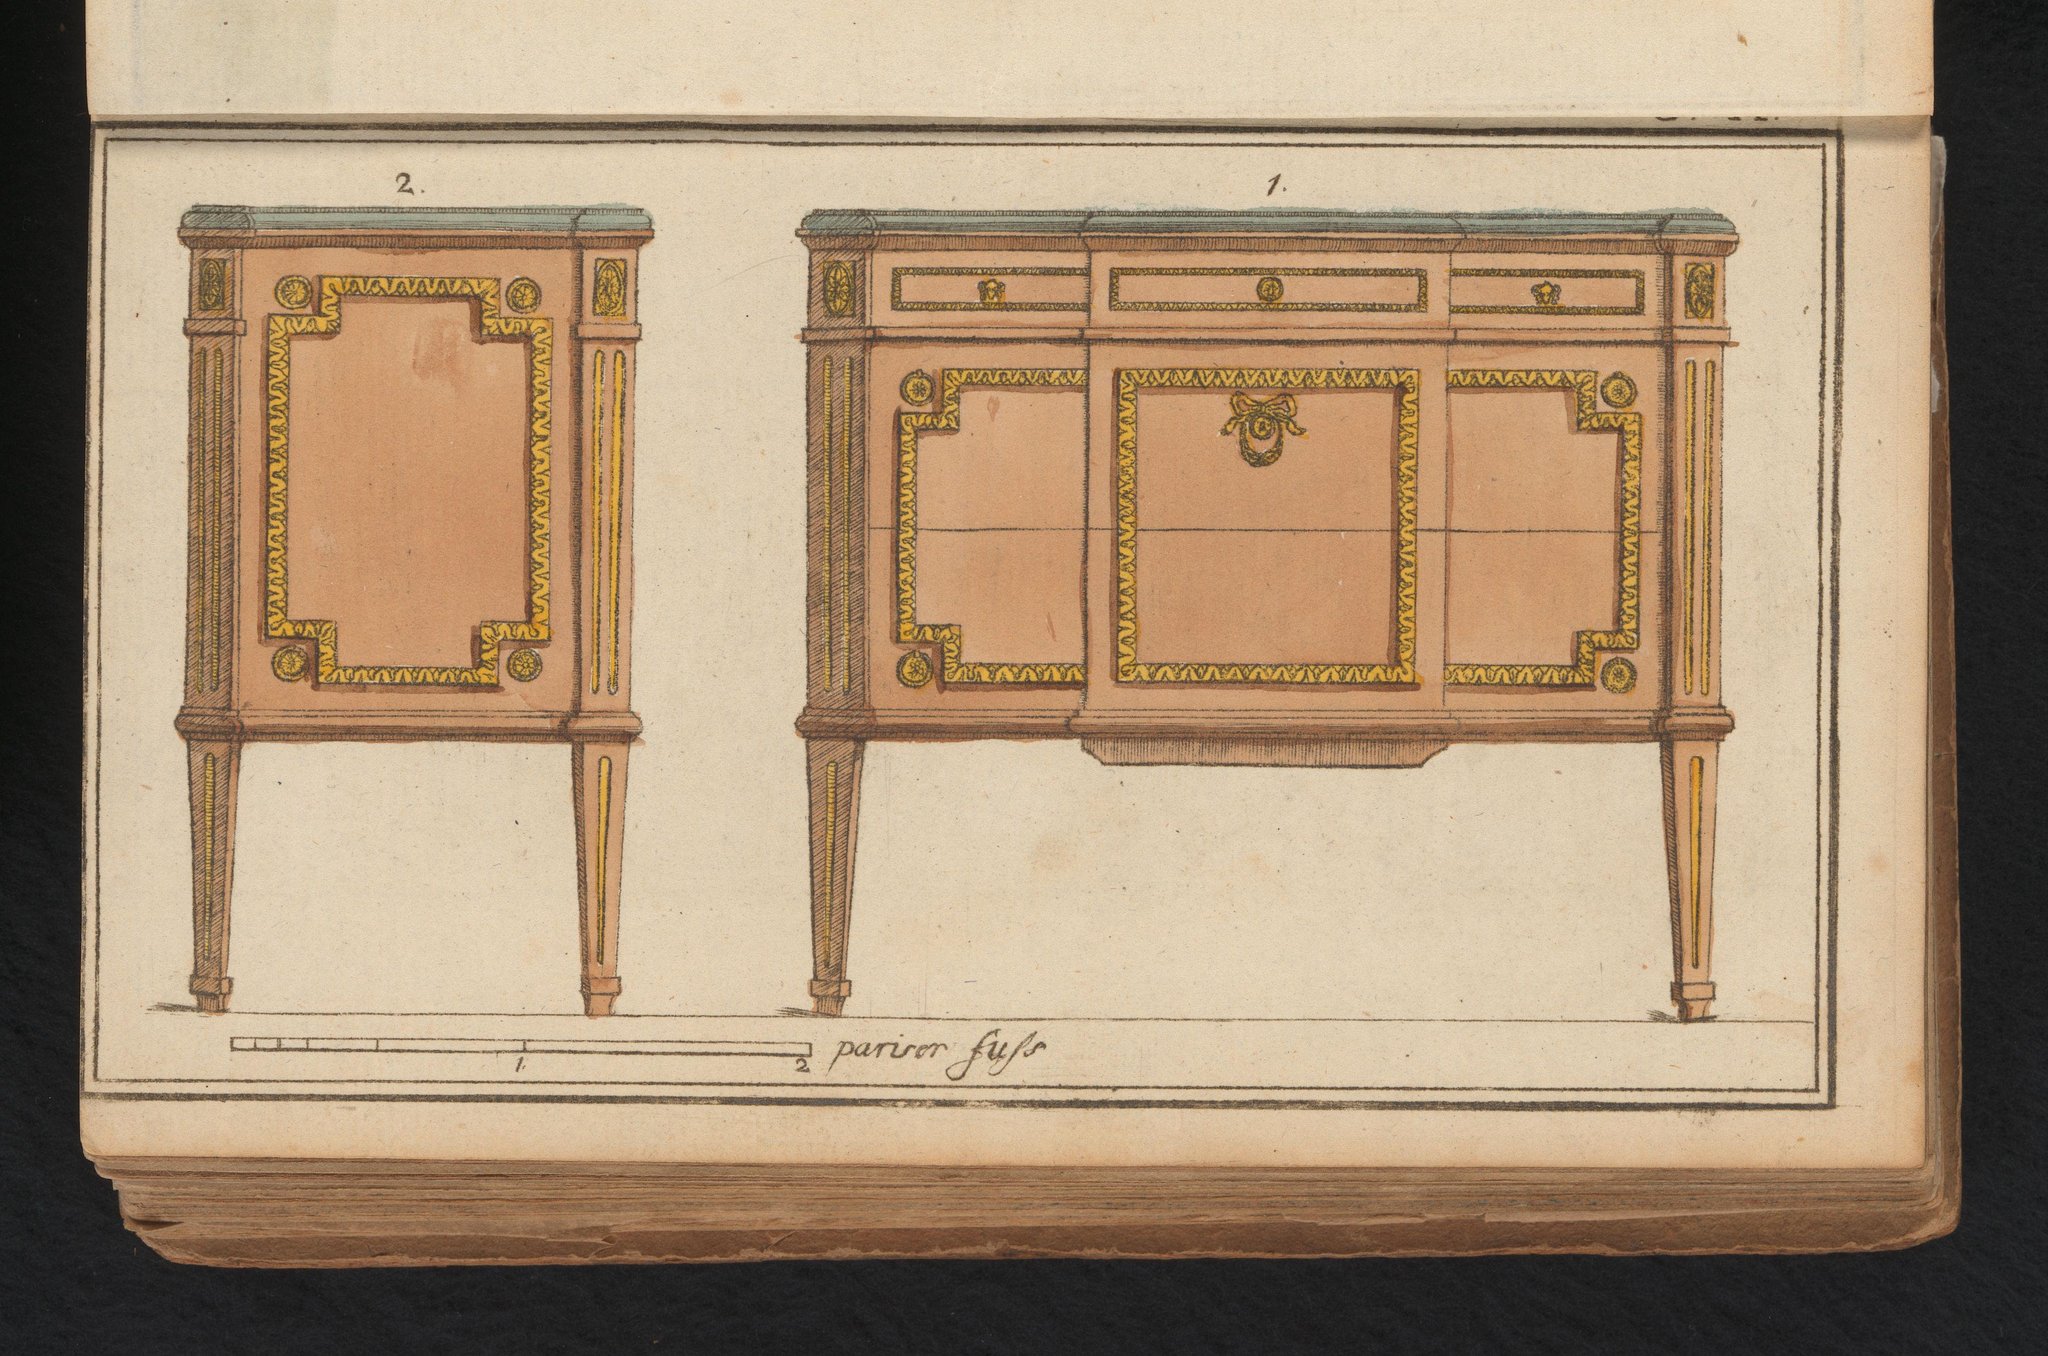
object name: magazine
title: Journal der Moden 1786. T. IX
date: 1786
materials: paper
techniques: etching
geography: gotha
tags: fashion plates